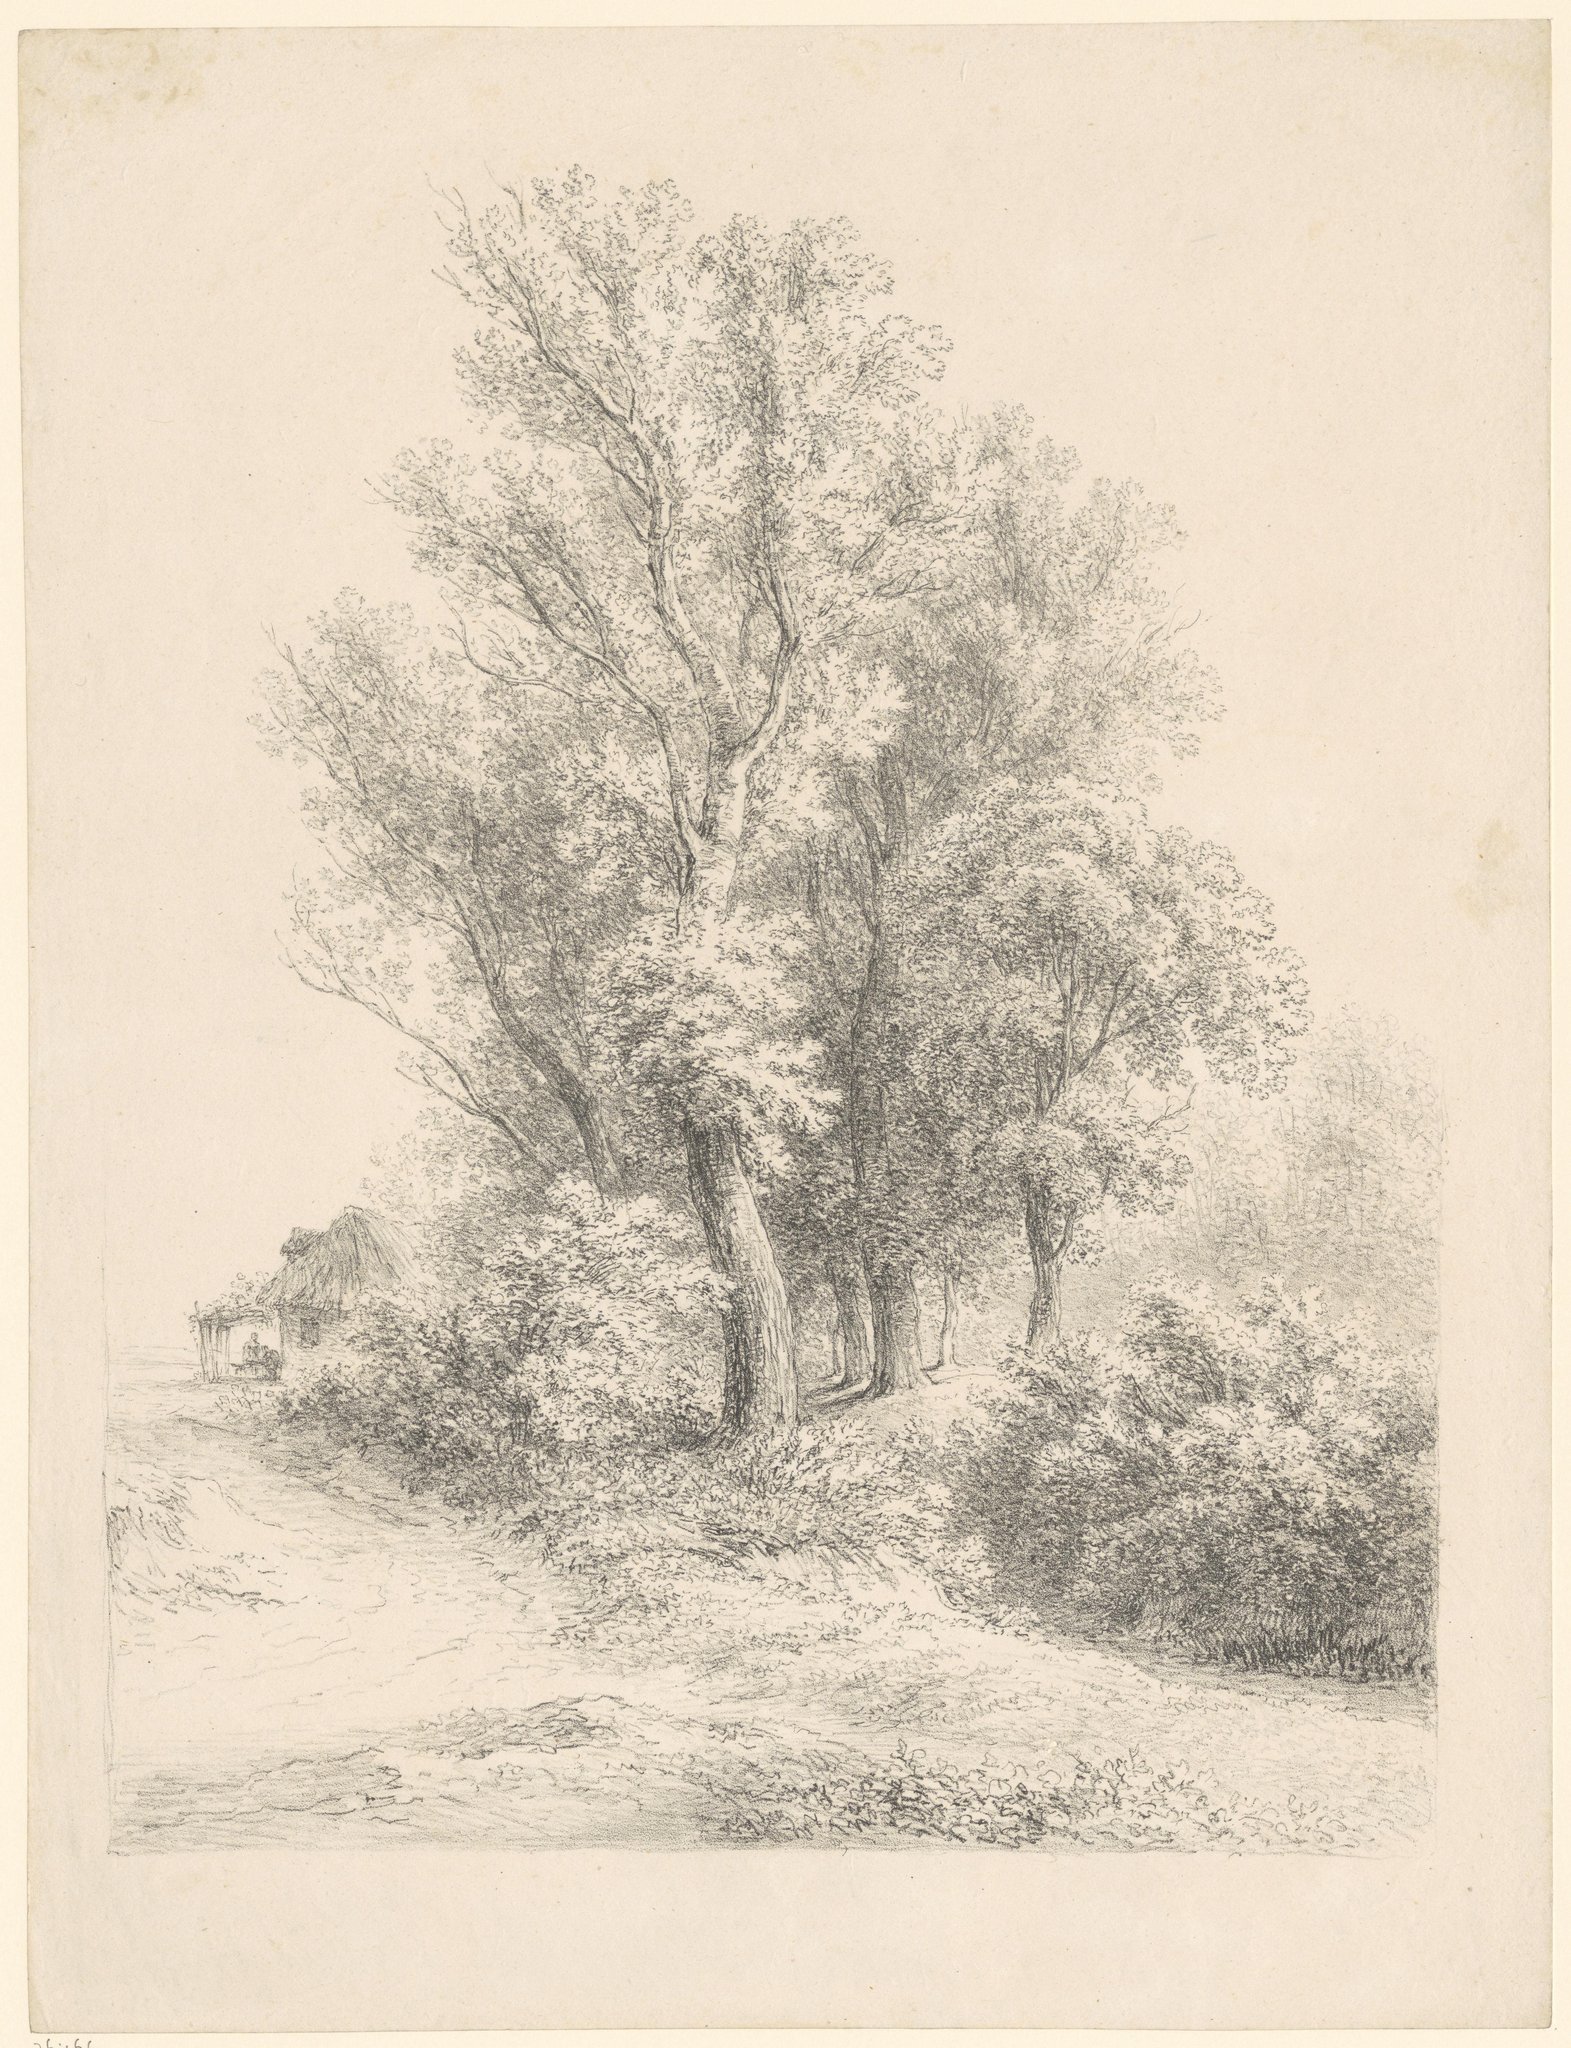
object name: print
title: Landschappen door Joseph Mössmer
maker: joseph mössmer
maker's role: print maker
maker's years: 1780-1845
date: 1818-1821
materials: paper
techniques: lithograph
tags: road, path, landscapes in the temperate zone (+ landscape with figures, staffage), farm or solitary house in landscape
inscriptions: collector's mark: Lugt 2228, collector's mark: Lugt 2760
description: Deze prent behoort waarschijnlijk tot een serie met zeventien landschappen door Joseph Mössmer uit ca. 1818-1821. Mogelijk is dit de elfde prent in de serie.